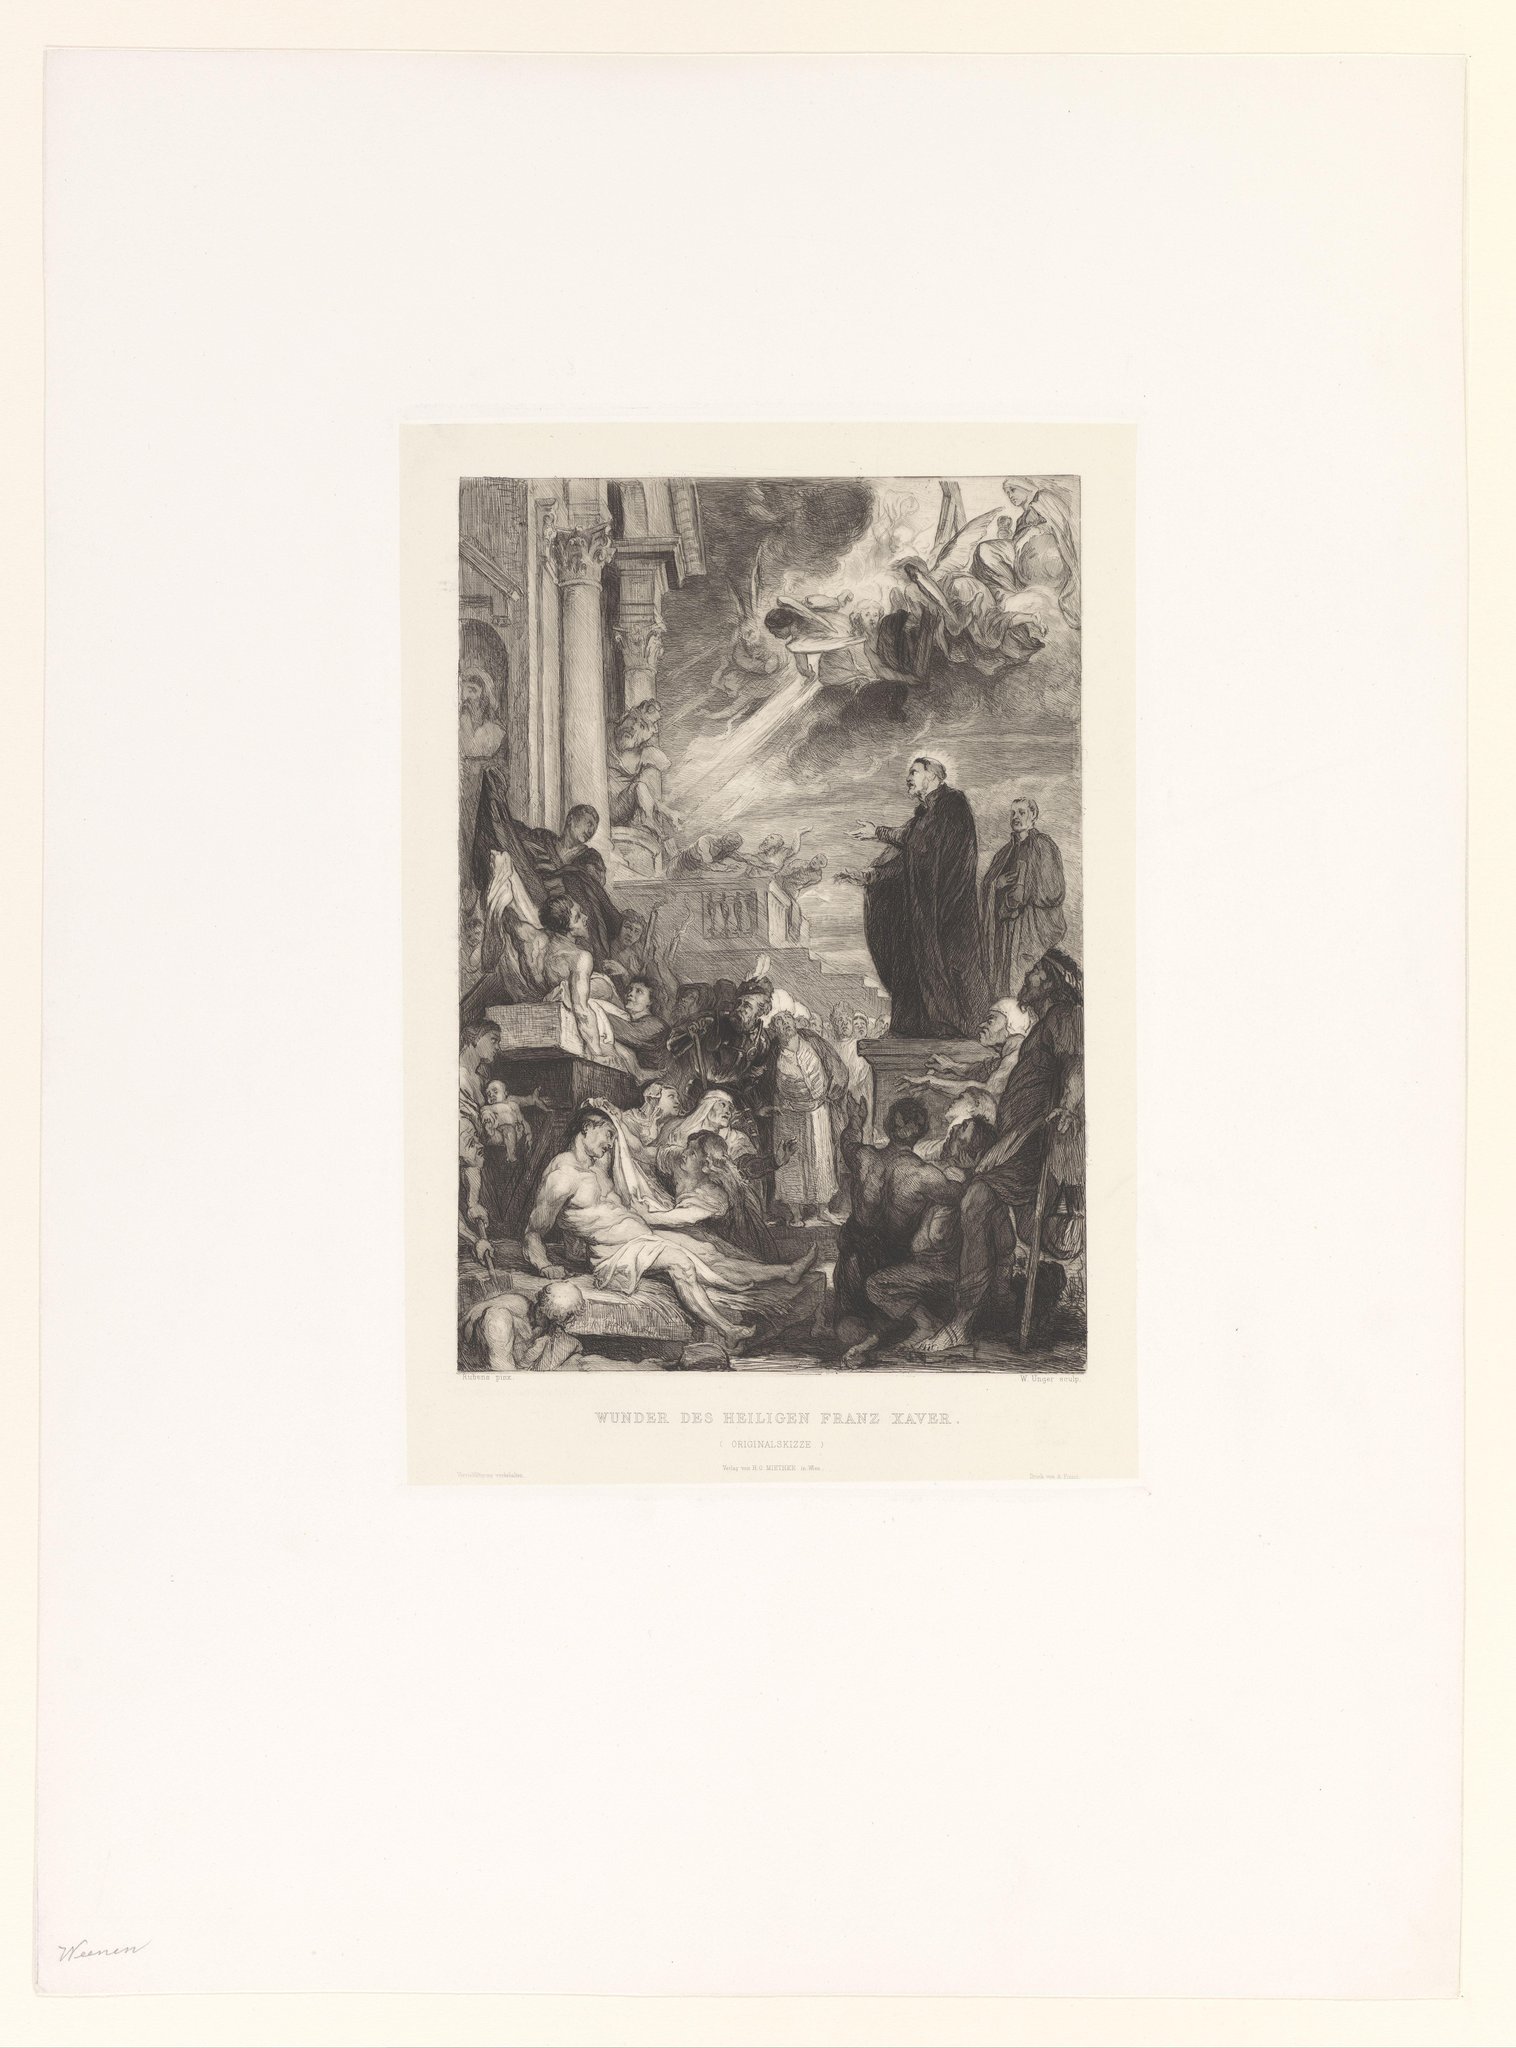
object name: print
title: Mirakel van de heilige Francis Xavier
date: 1861-1889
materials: paper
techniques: etching, intaglio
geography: vienna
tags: st. francis xavier as missionary in the east indies performing miracles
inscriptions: collector's mark: Lugt 2228